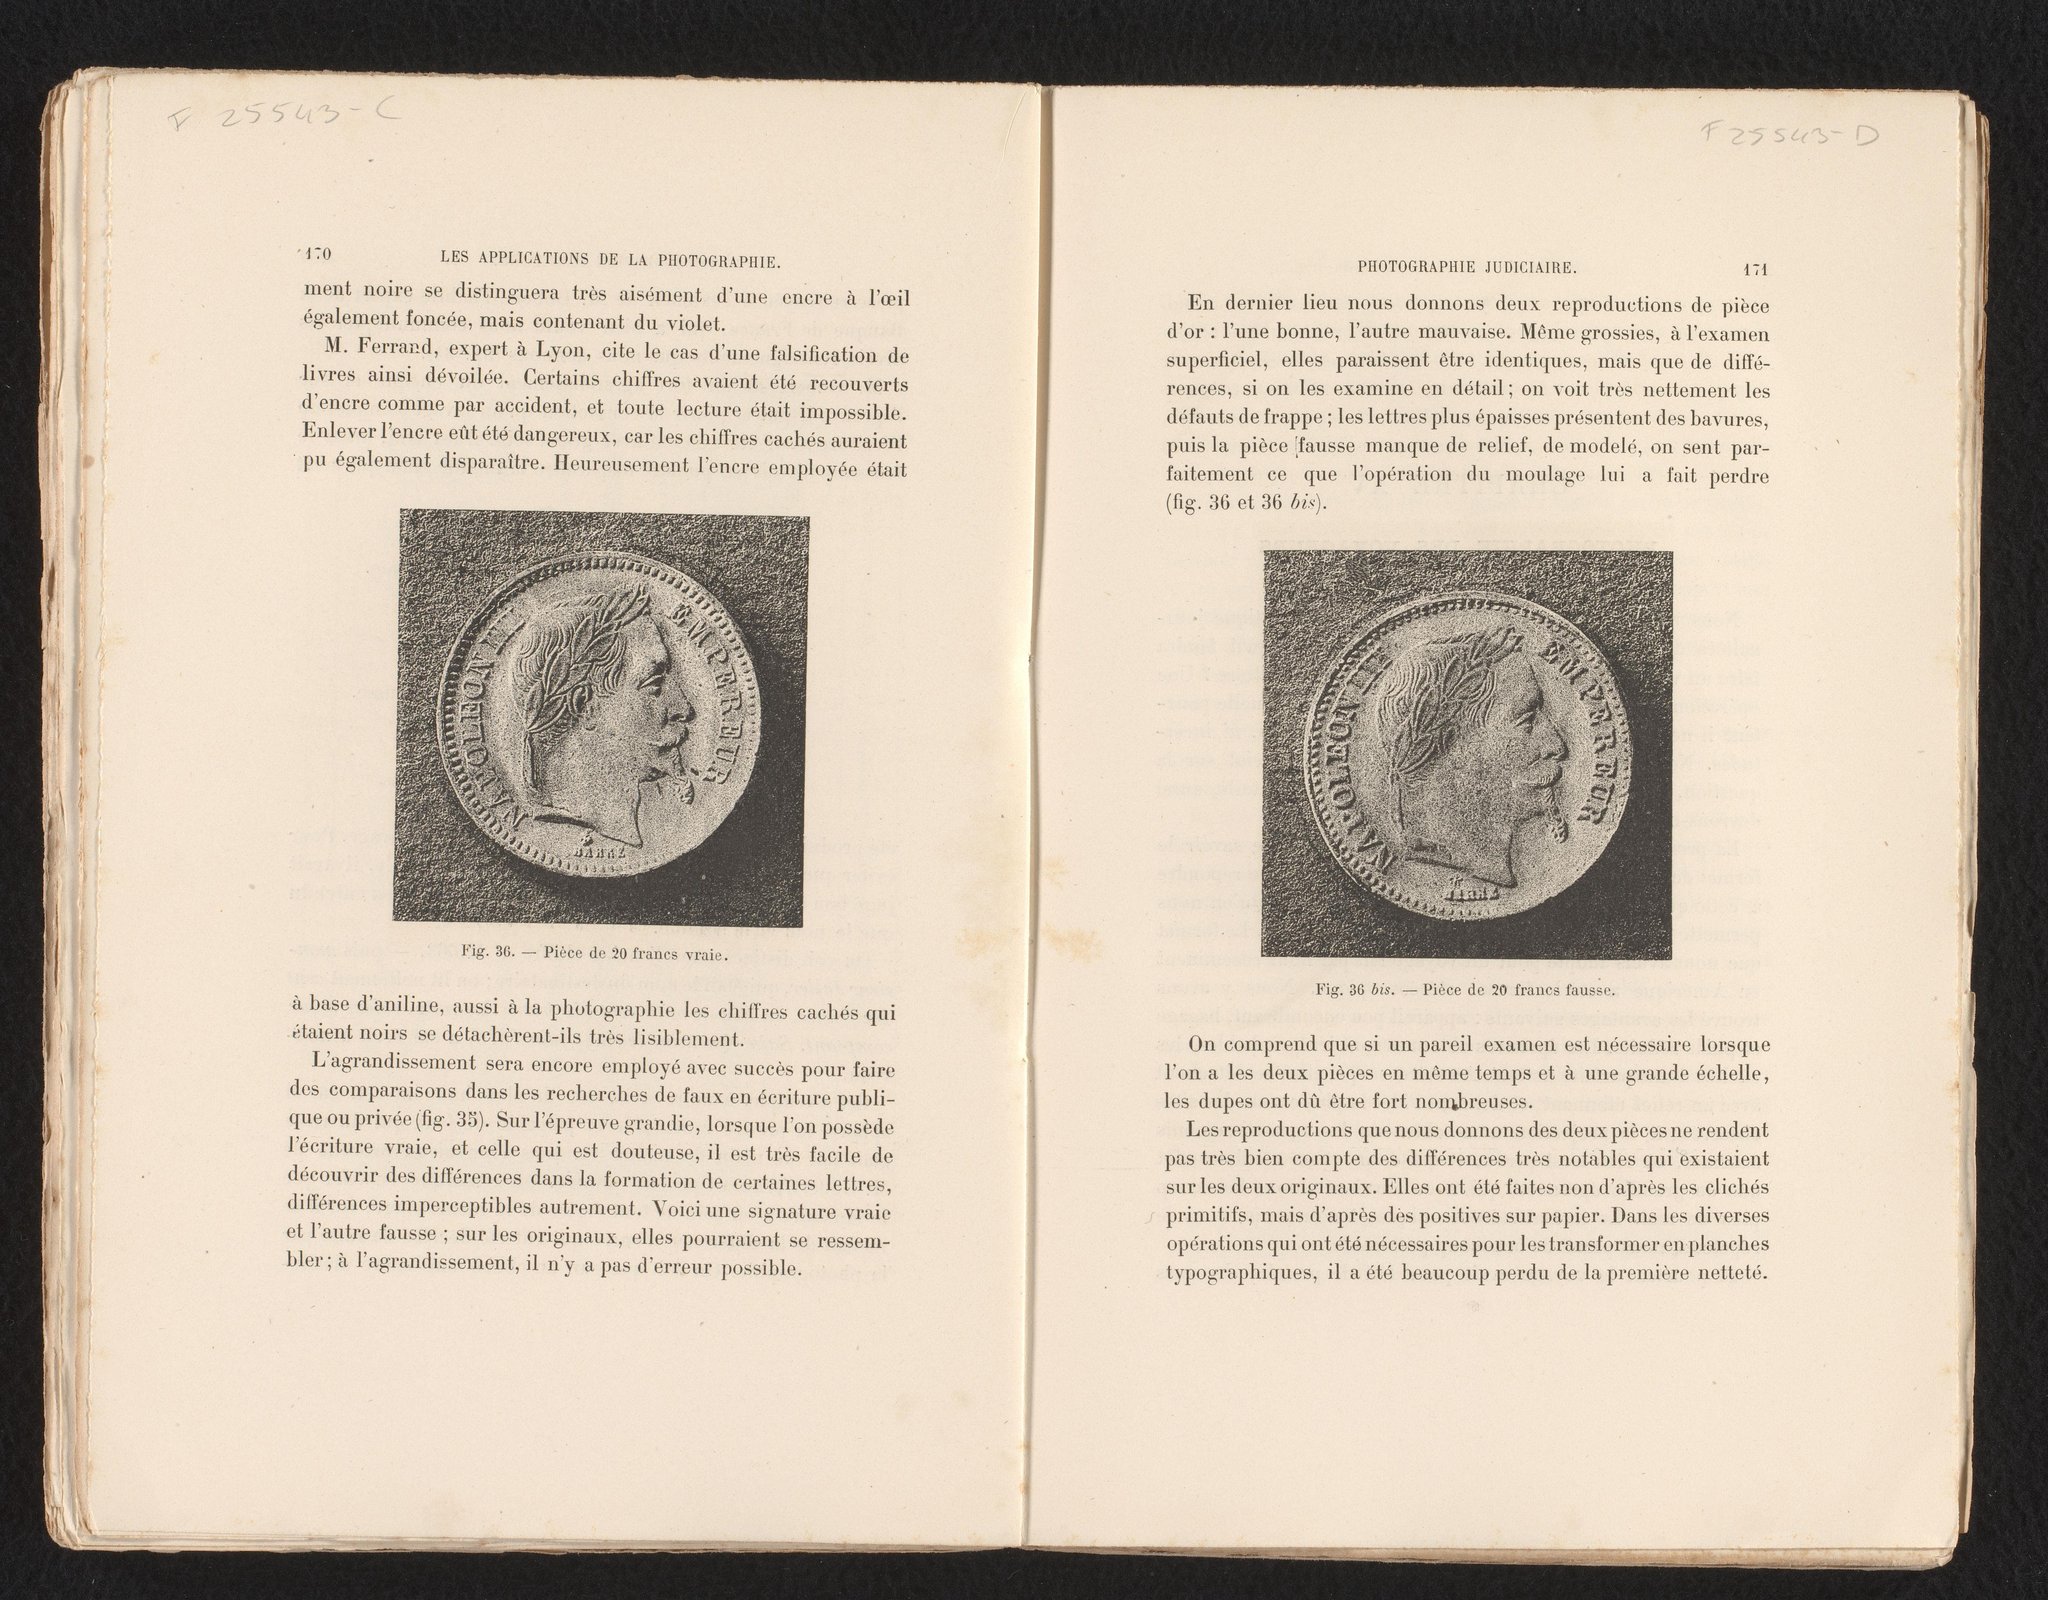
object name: photomechanical print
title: Pièce de 20 francs fausse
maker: Anonymous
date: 1883-1888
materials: paper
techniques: collo-autotype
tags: coin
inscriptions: number: ‘Fig. 36 bis.’